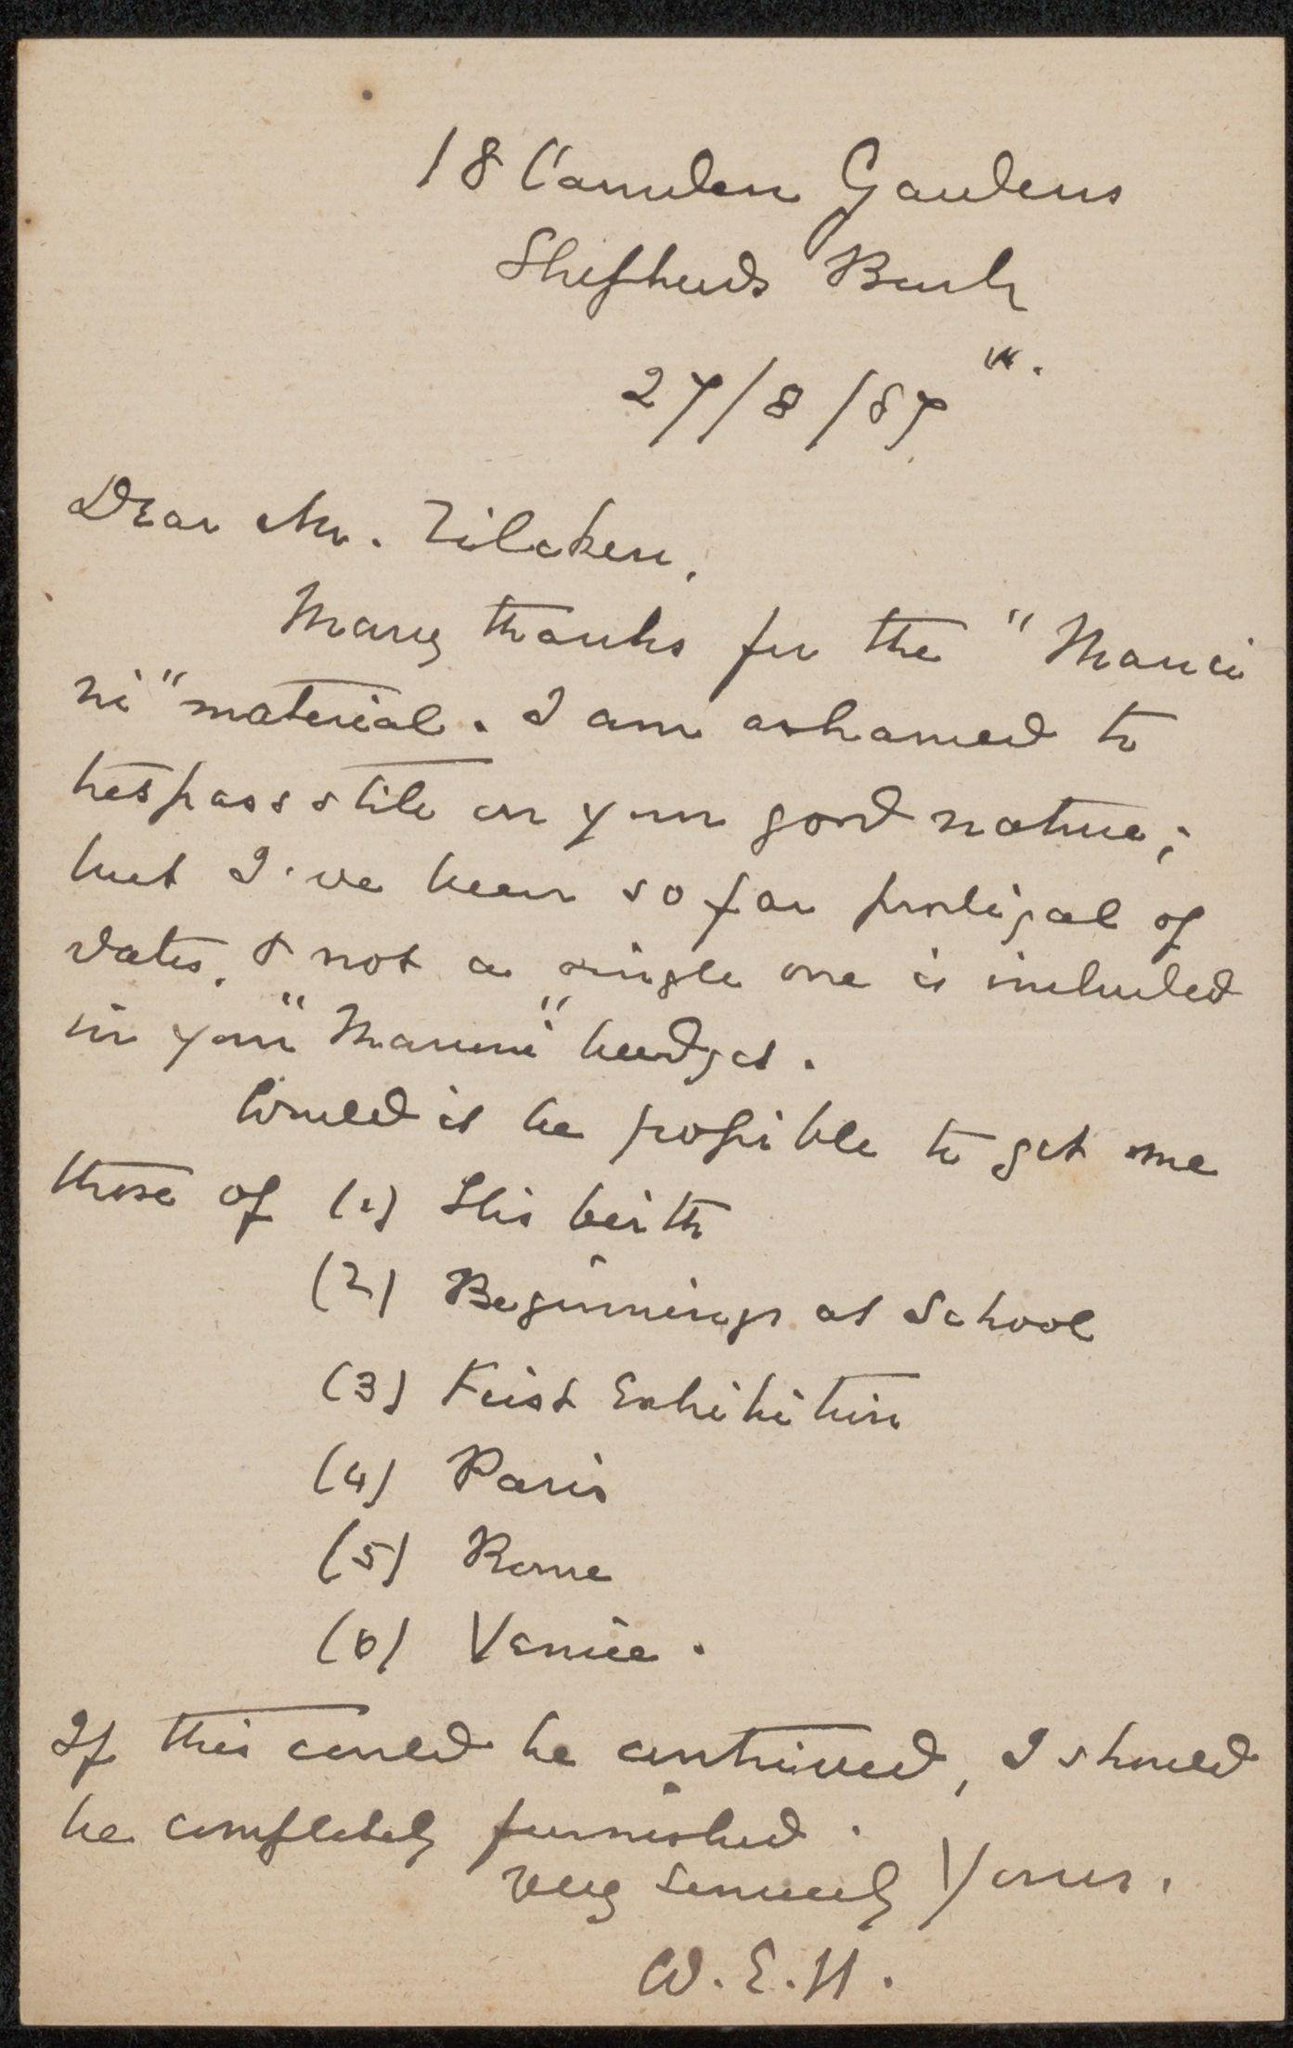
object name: letter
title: Brief aan Philip Zilcken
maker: william ernest henley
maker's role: criticus, dichter, redacteur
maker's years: 1849-1903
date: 1887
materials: ink, paper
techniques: pen, writing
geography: shepherd's bush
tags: the hague, draughtsman, philip zilcken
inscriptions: collector's mark: ‘RPK’